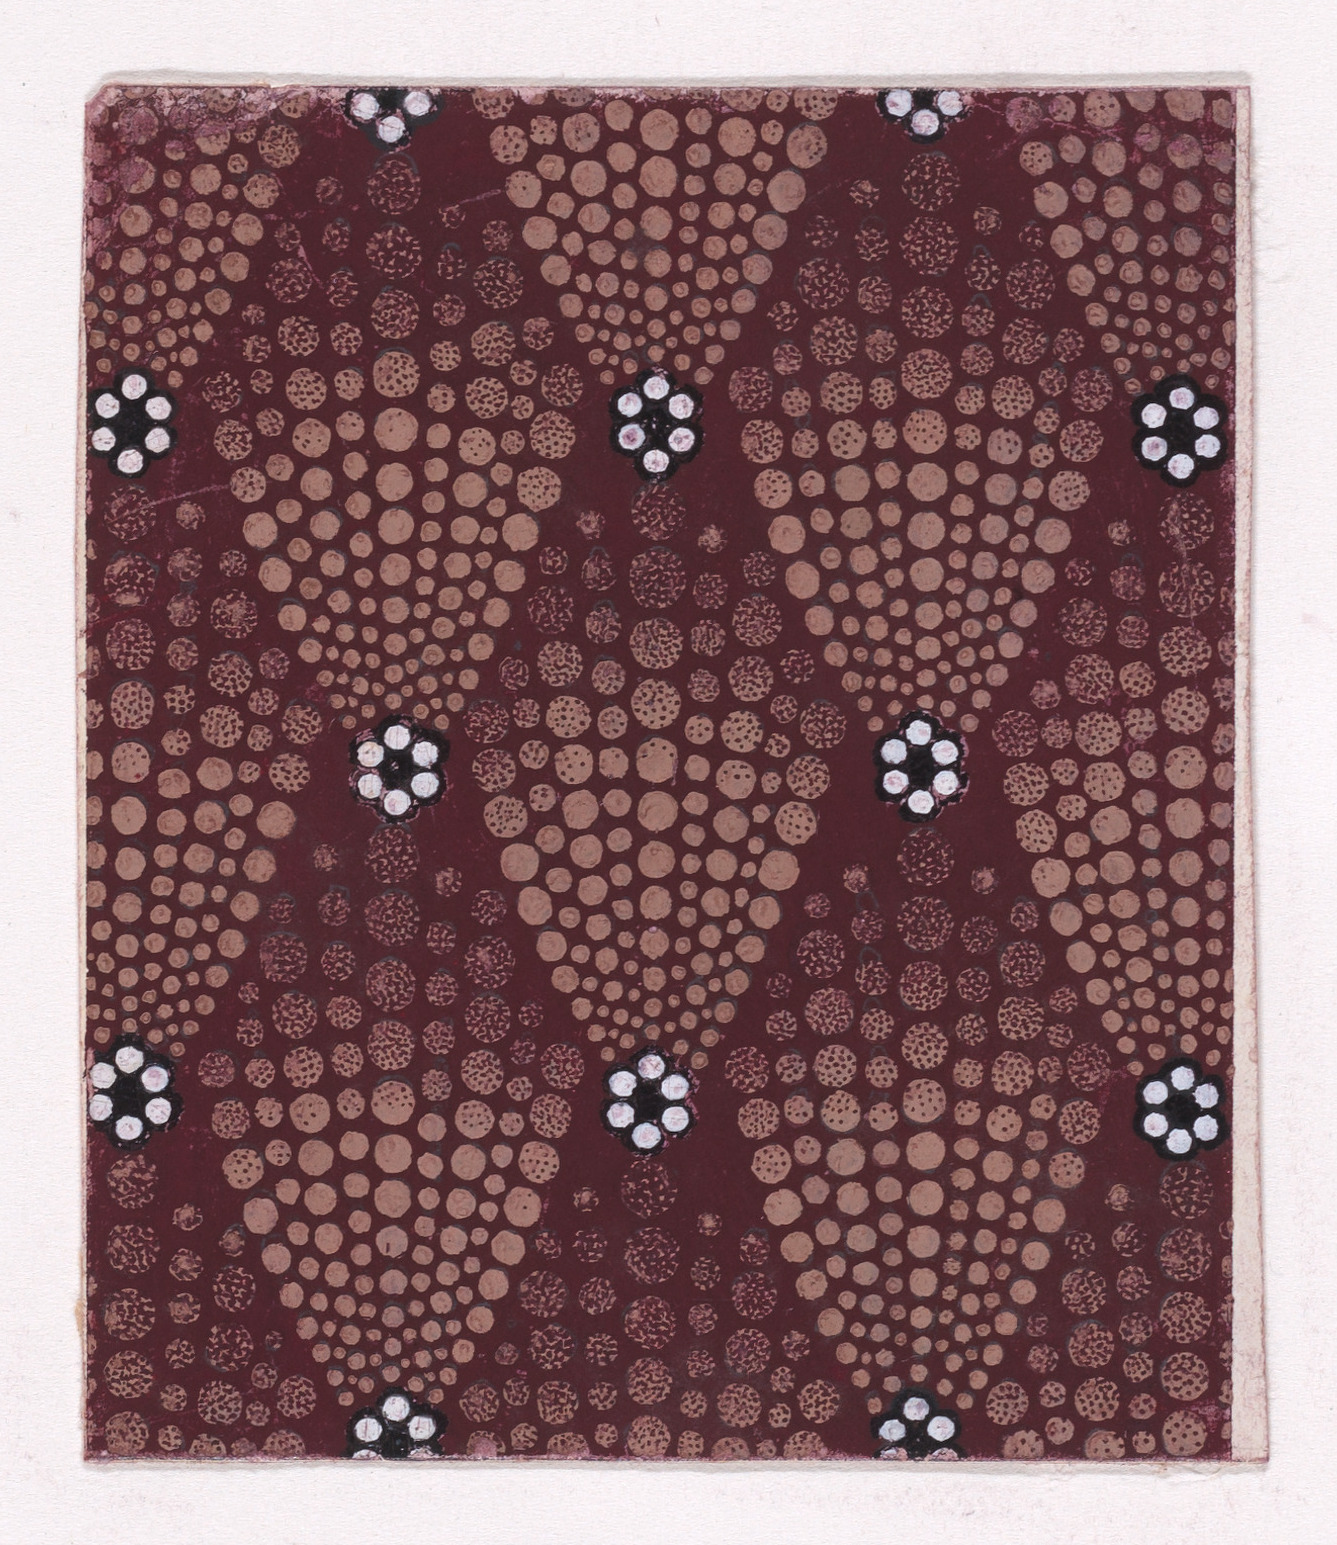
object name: drawing ornament architecture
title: Textile Design with Rosettes of Pearls Flanked with Abstract Palmettes of Dots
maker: anonymous, alsatian, 19th century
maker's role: artist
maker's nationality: alsatian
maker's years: 1800-1900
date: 1840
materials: gouache